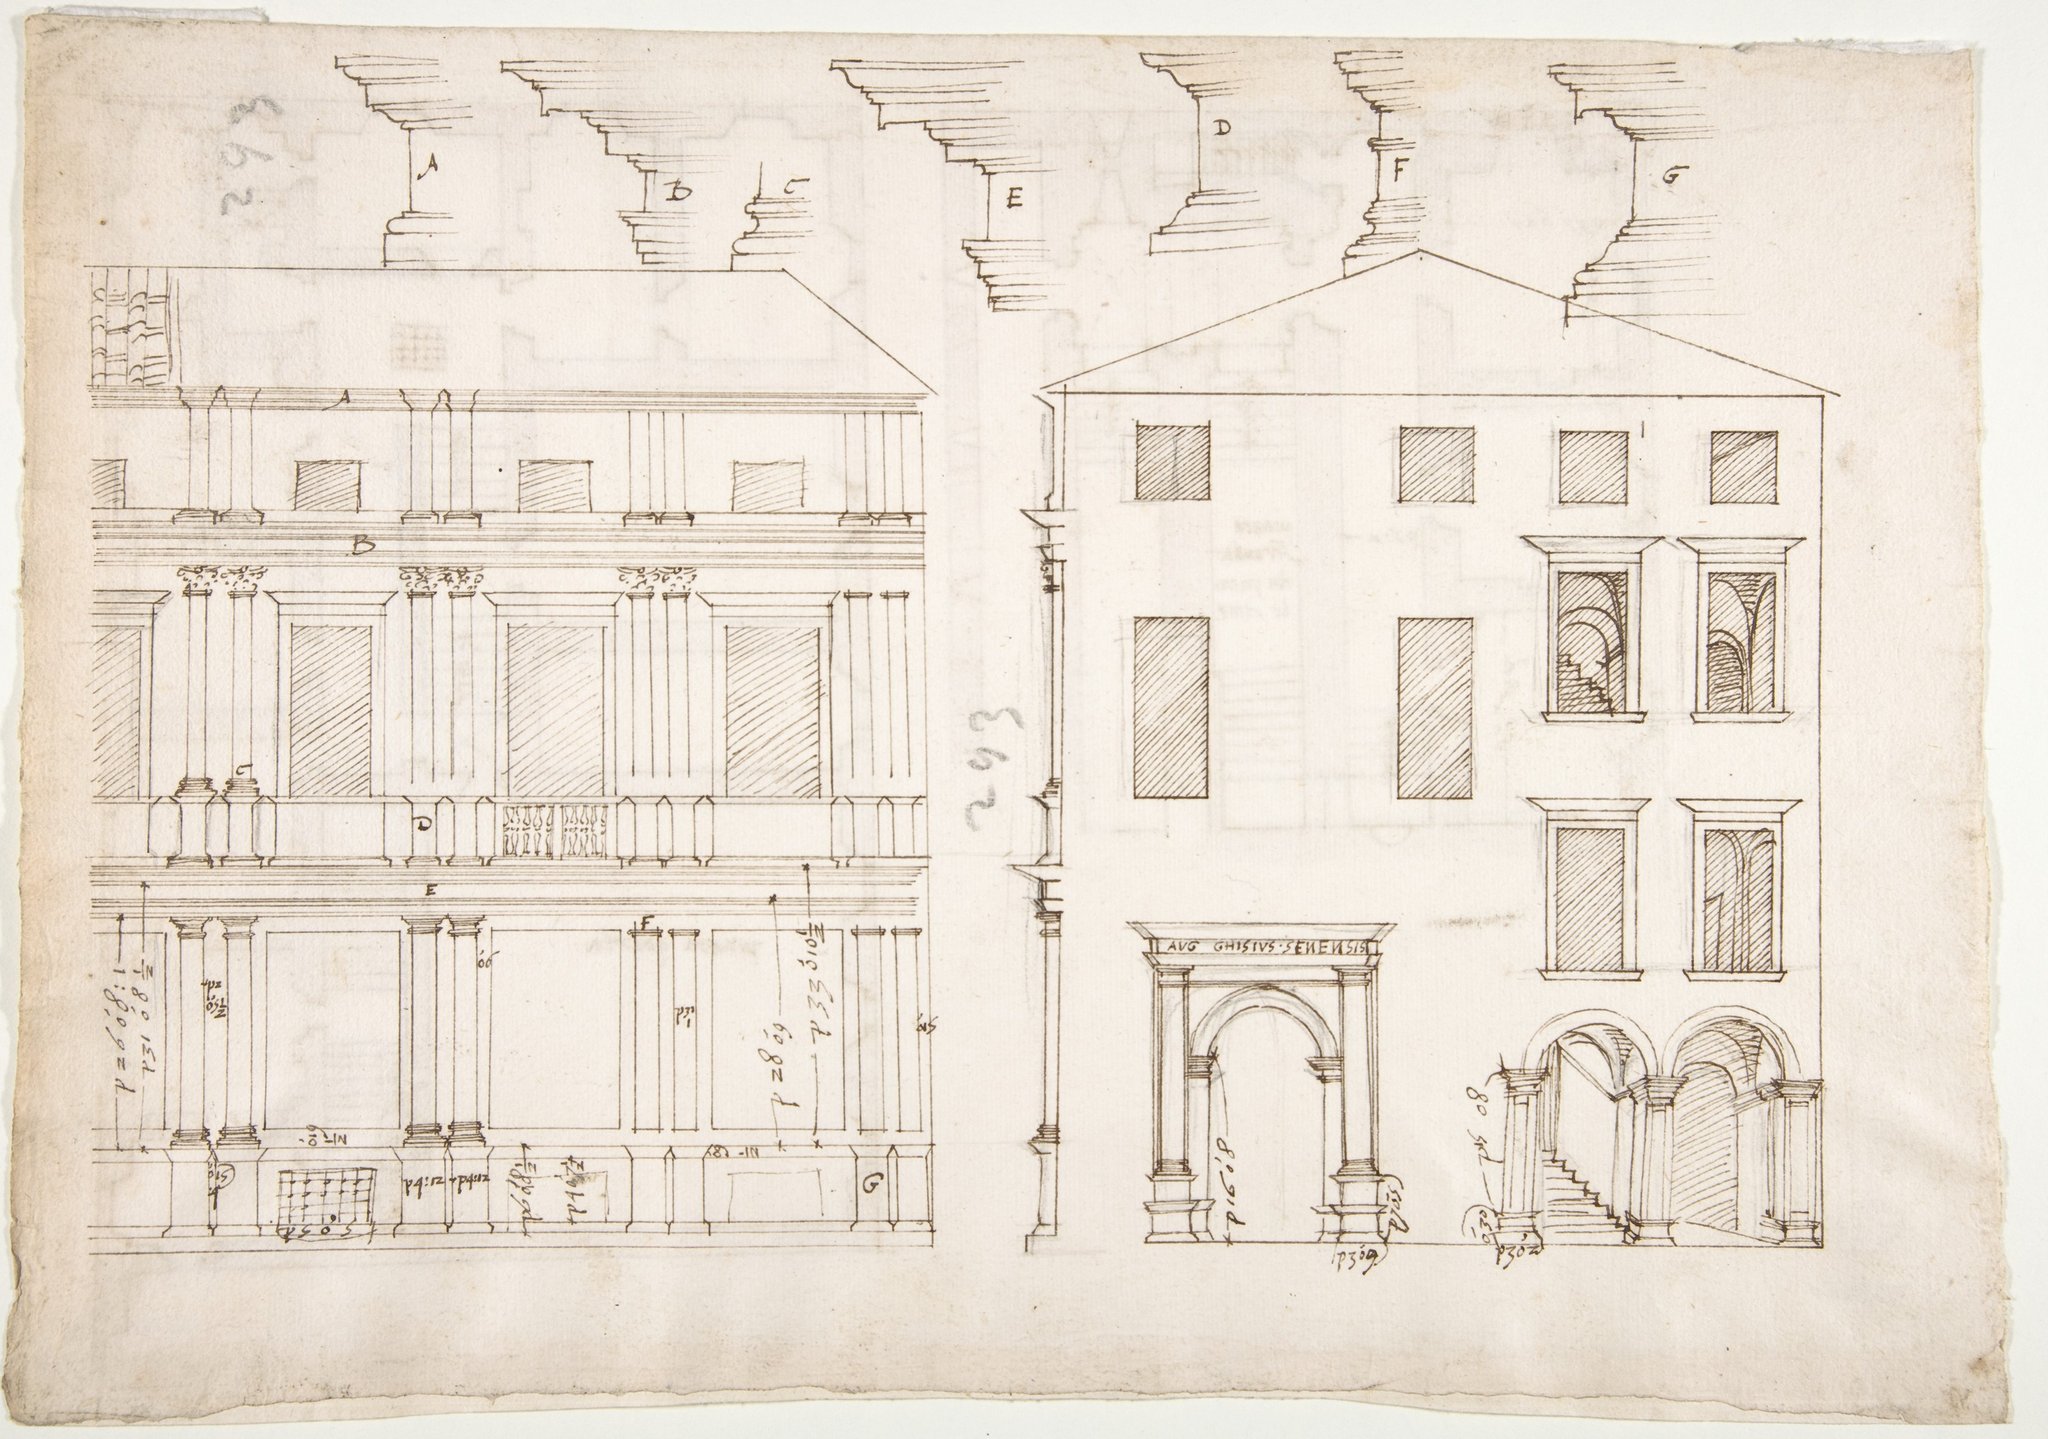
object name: drawing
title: Villa Farnesina, Stables, half front elevation and end elevation (recto) Palazzo Salviati-Adimari, plan (verso)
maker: anonymous, french, 16th century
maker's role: draftsman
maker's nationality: french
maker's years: 1500-1600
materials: chalk, ink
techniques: incising, wash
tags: architecture,buildings